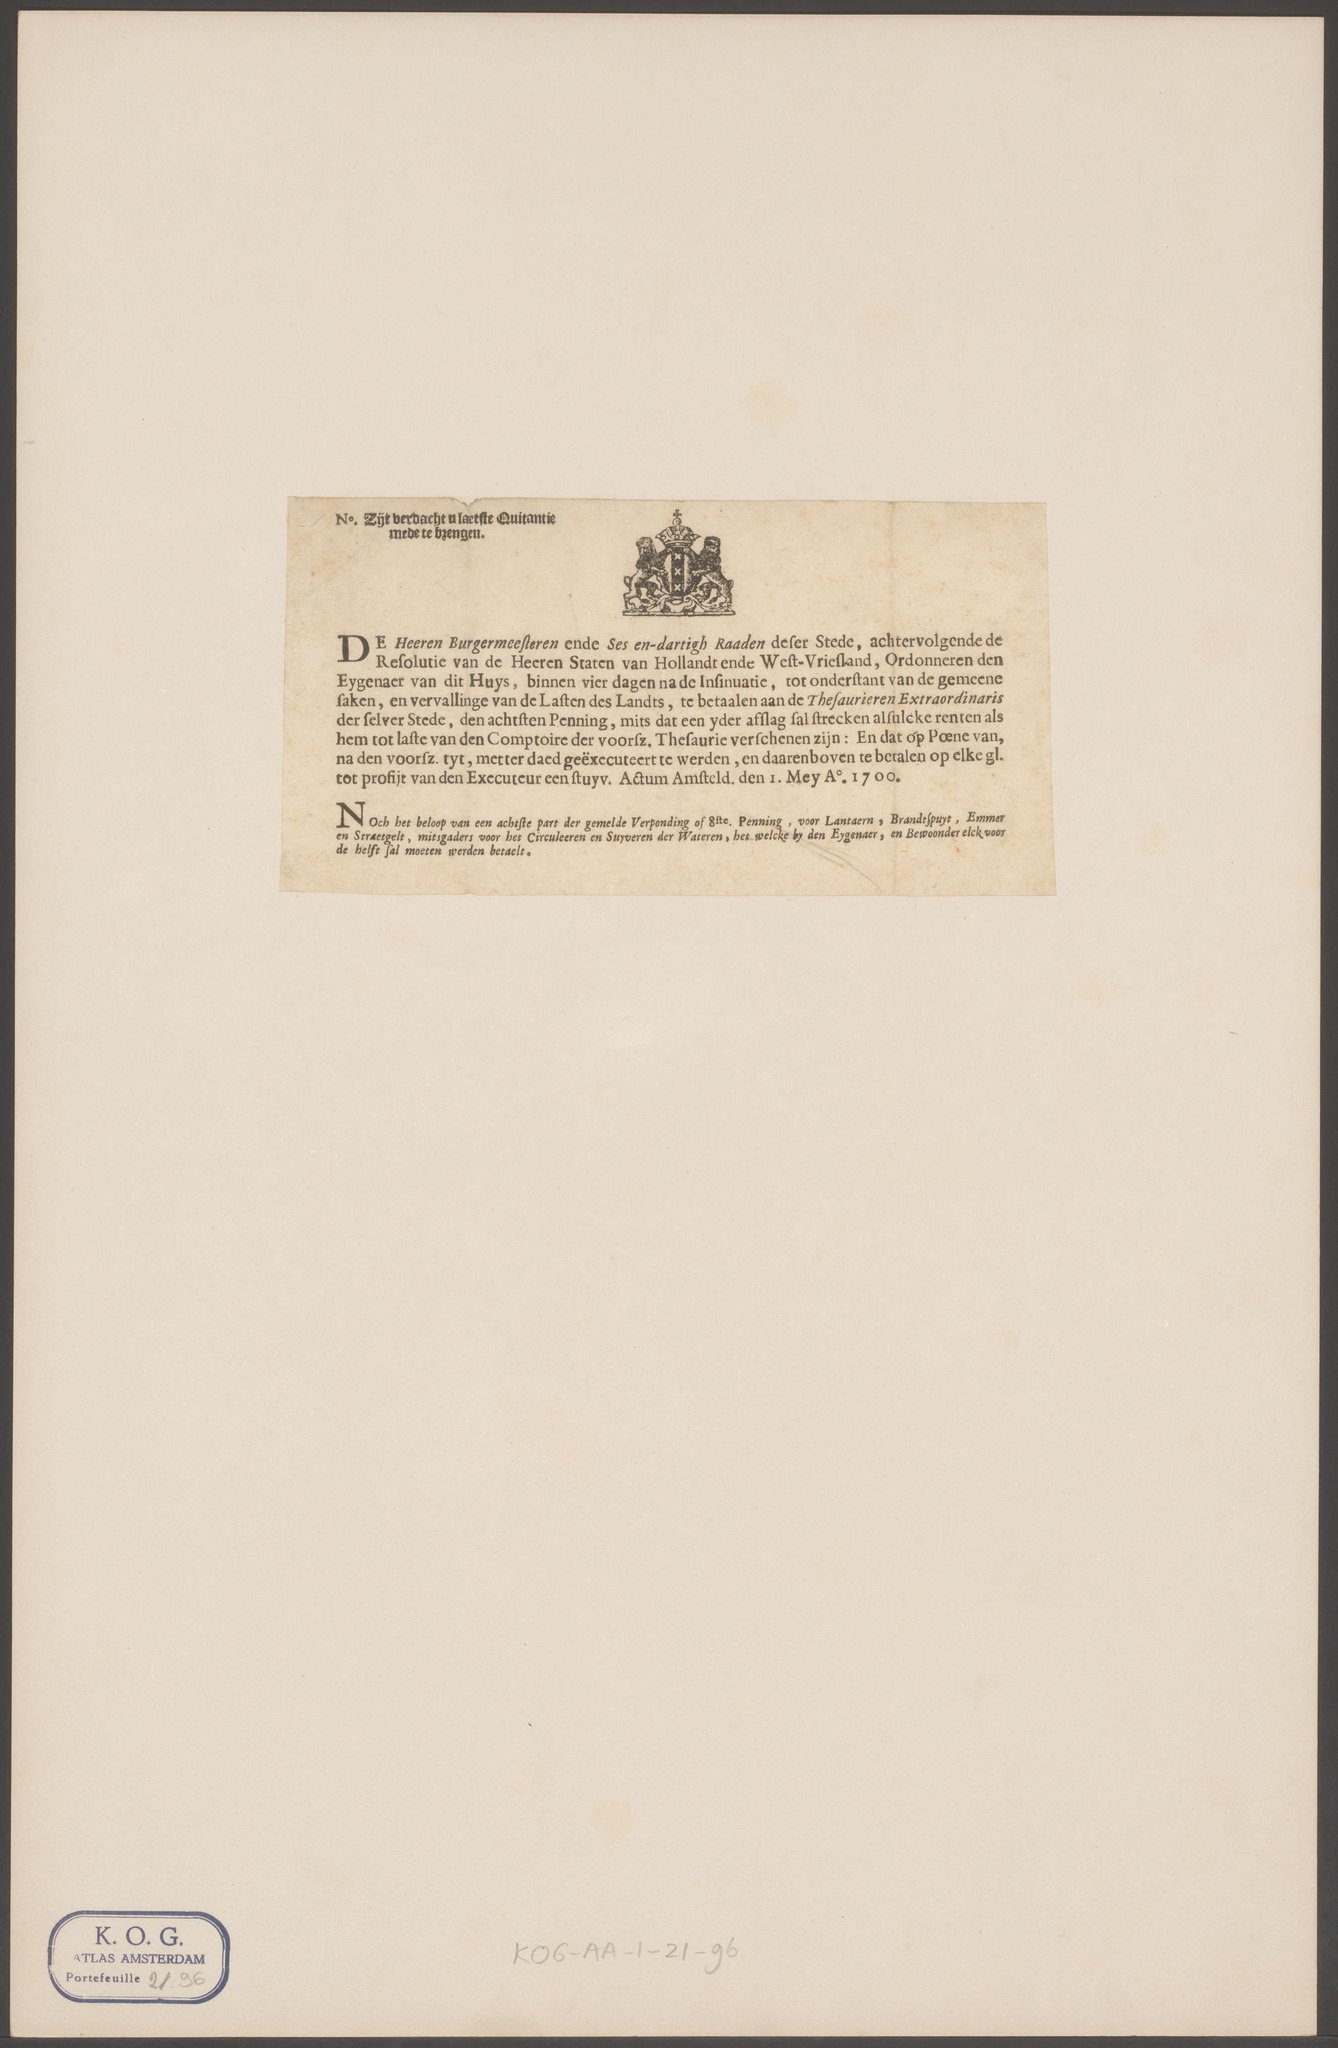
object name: document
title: Aanslagbiljet voor de eigenaar van een woning te Amsterdam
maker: Anonymous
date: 1700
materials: paper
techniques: letterpress printing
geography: amsterdam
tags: tax collection, tax payment, amsterdam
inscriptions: collector's mark: Lugt 1641b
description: Inzake betaling van de achtste penning op 1 mei 1700 . Onderwerpsrubriek binnen de Atlas Amsterdam: Belastingen.